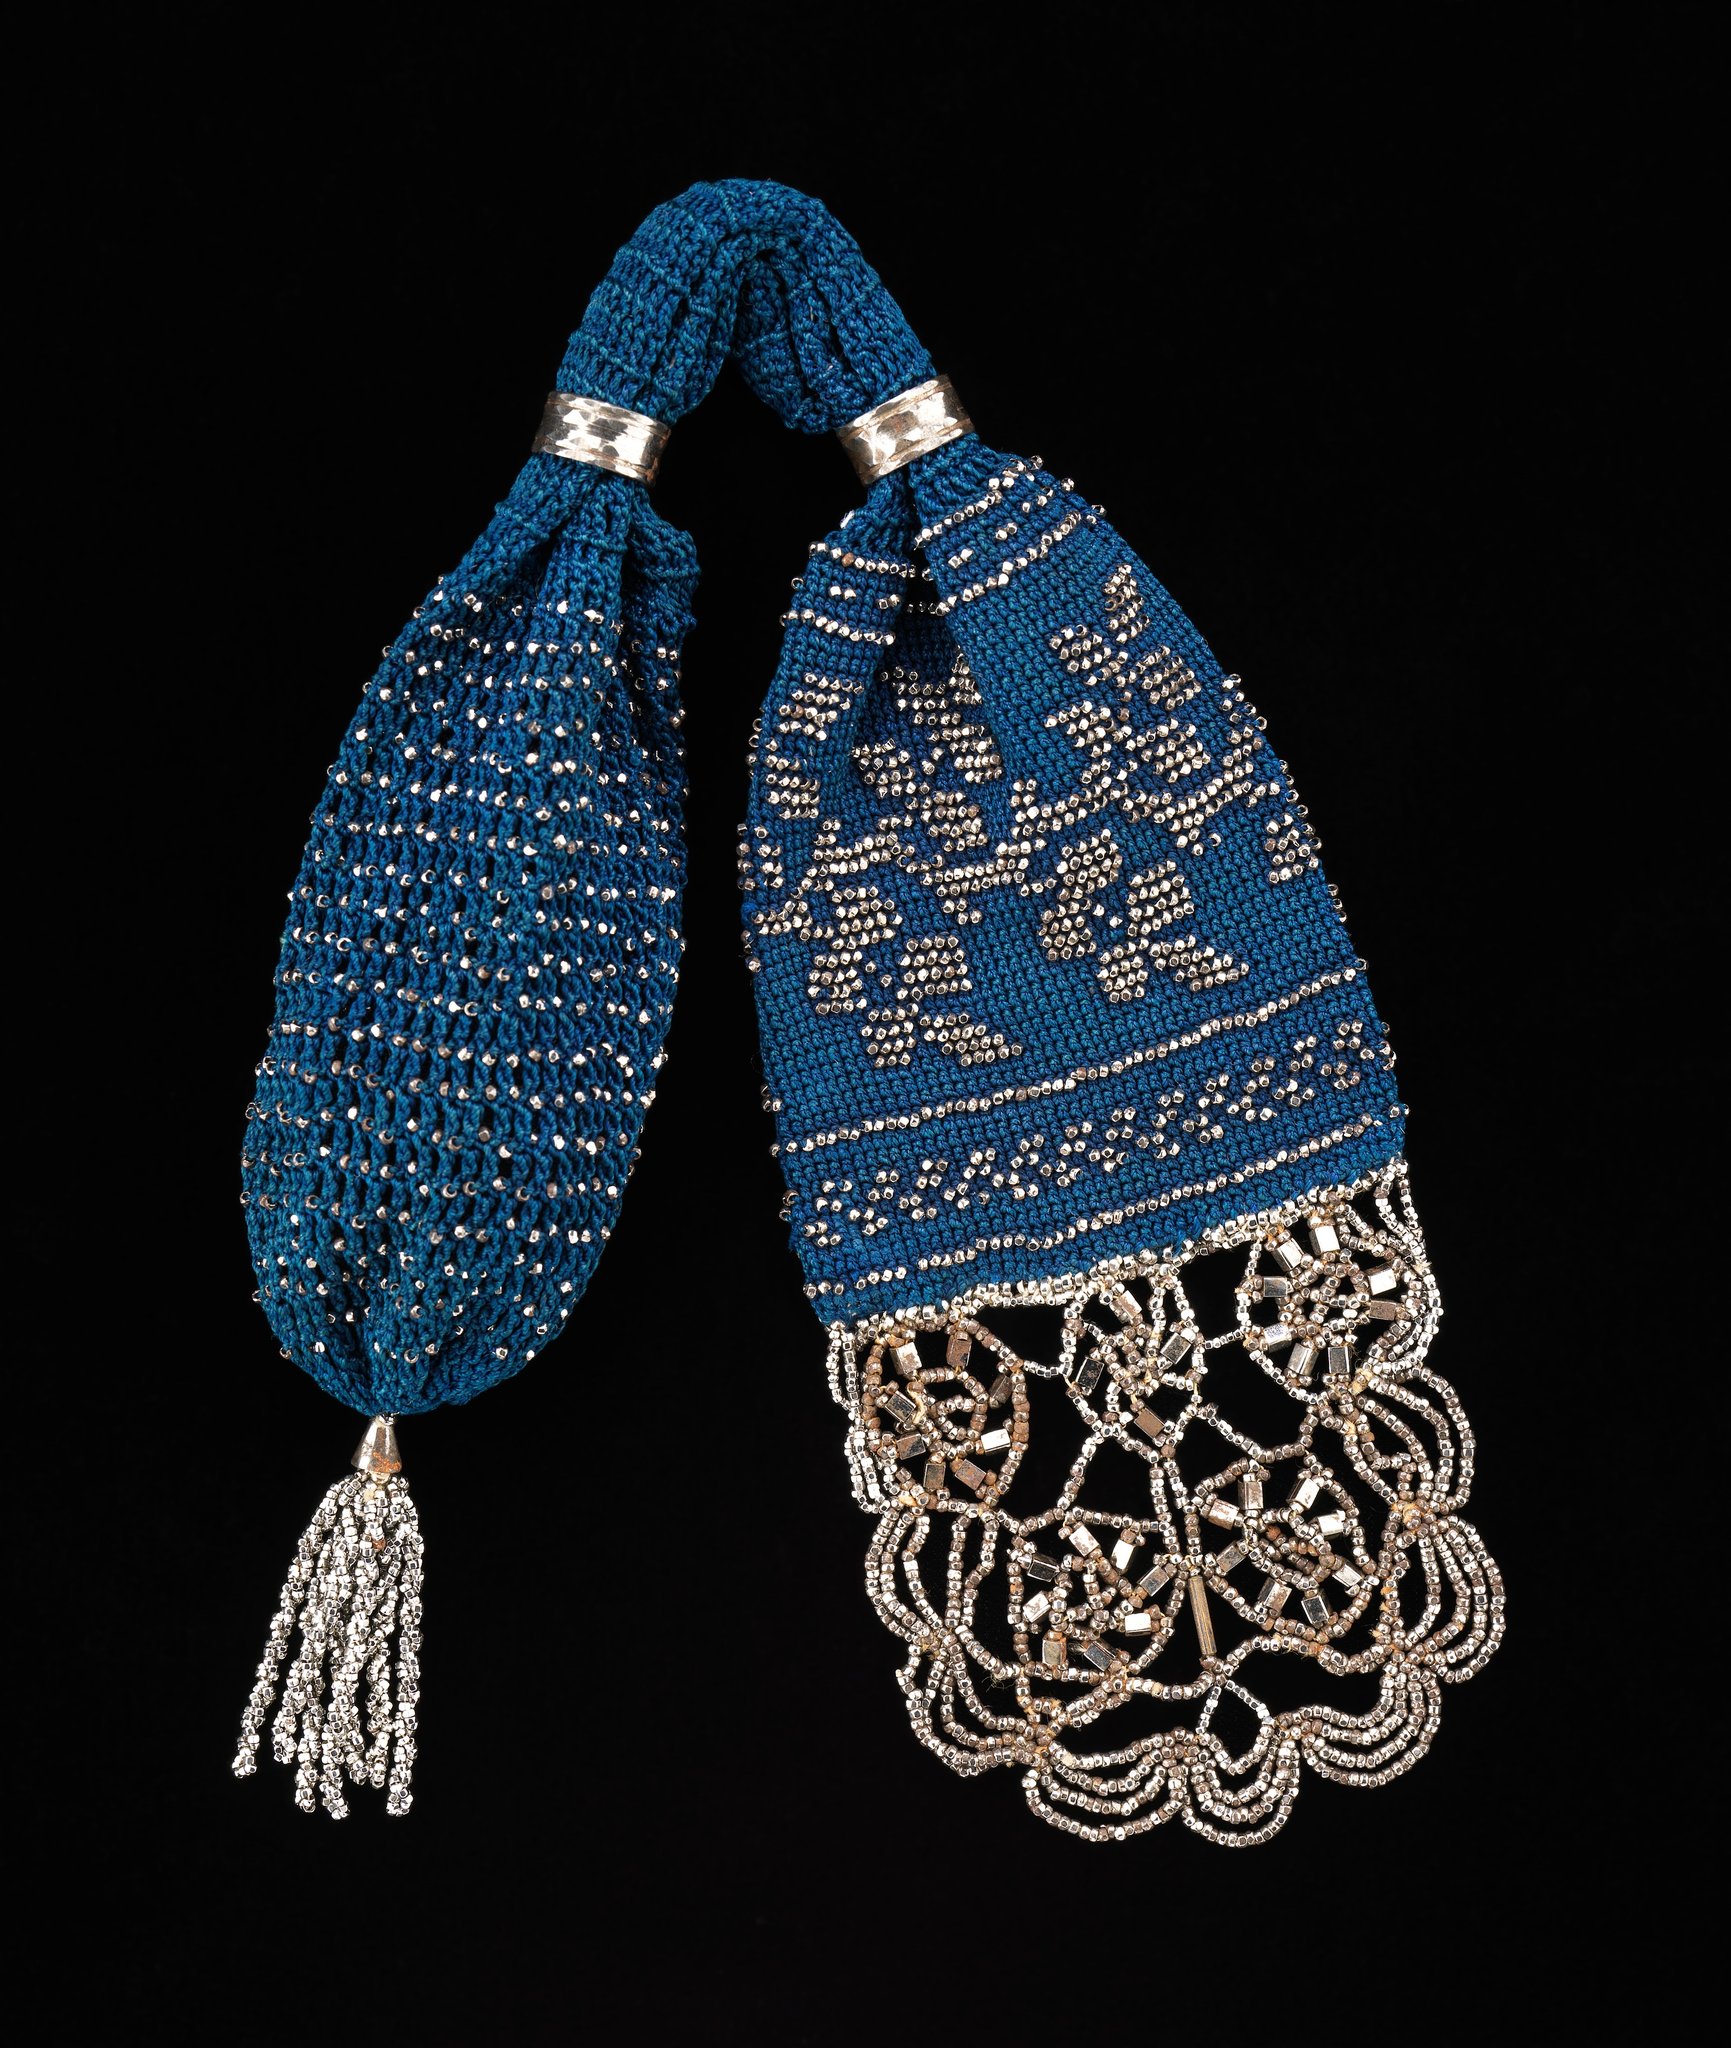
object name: miser's purse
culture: american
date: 1851-1875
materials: metal, silk